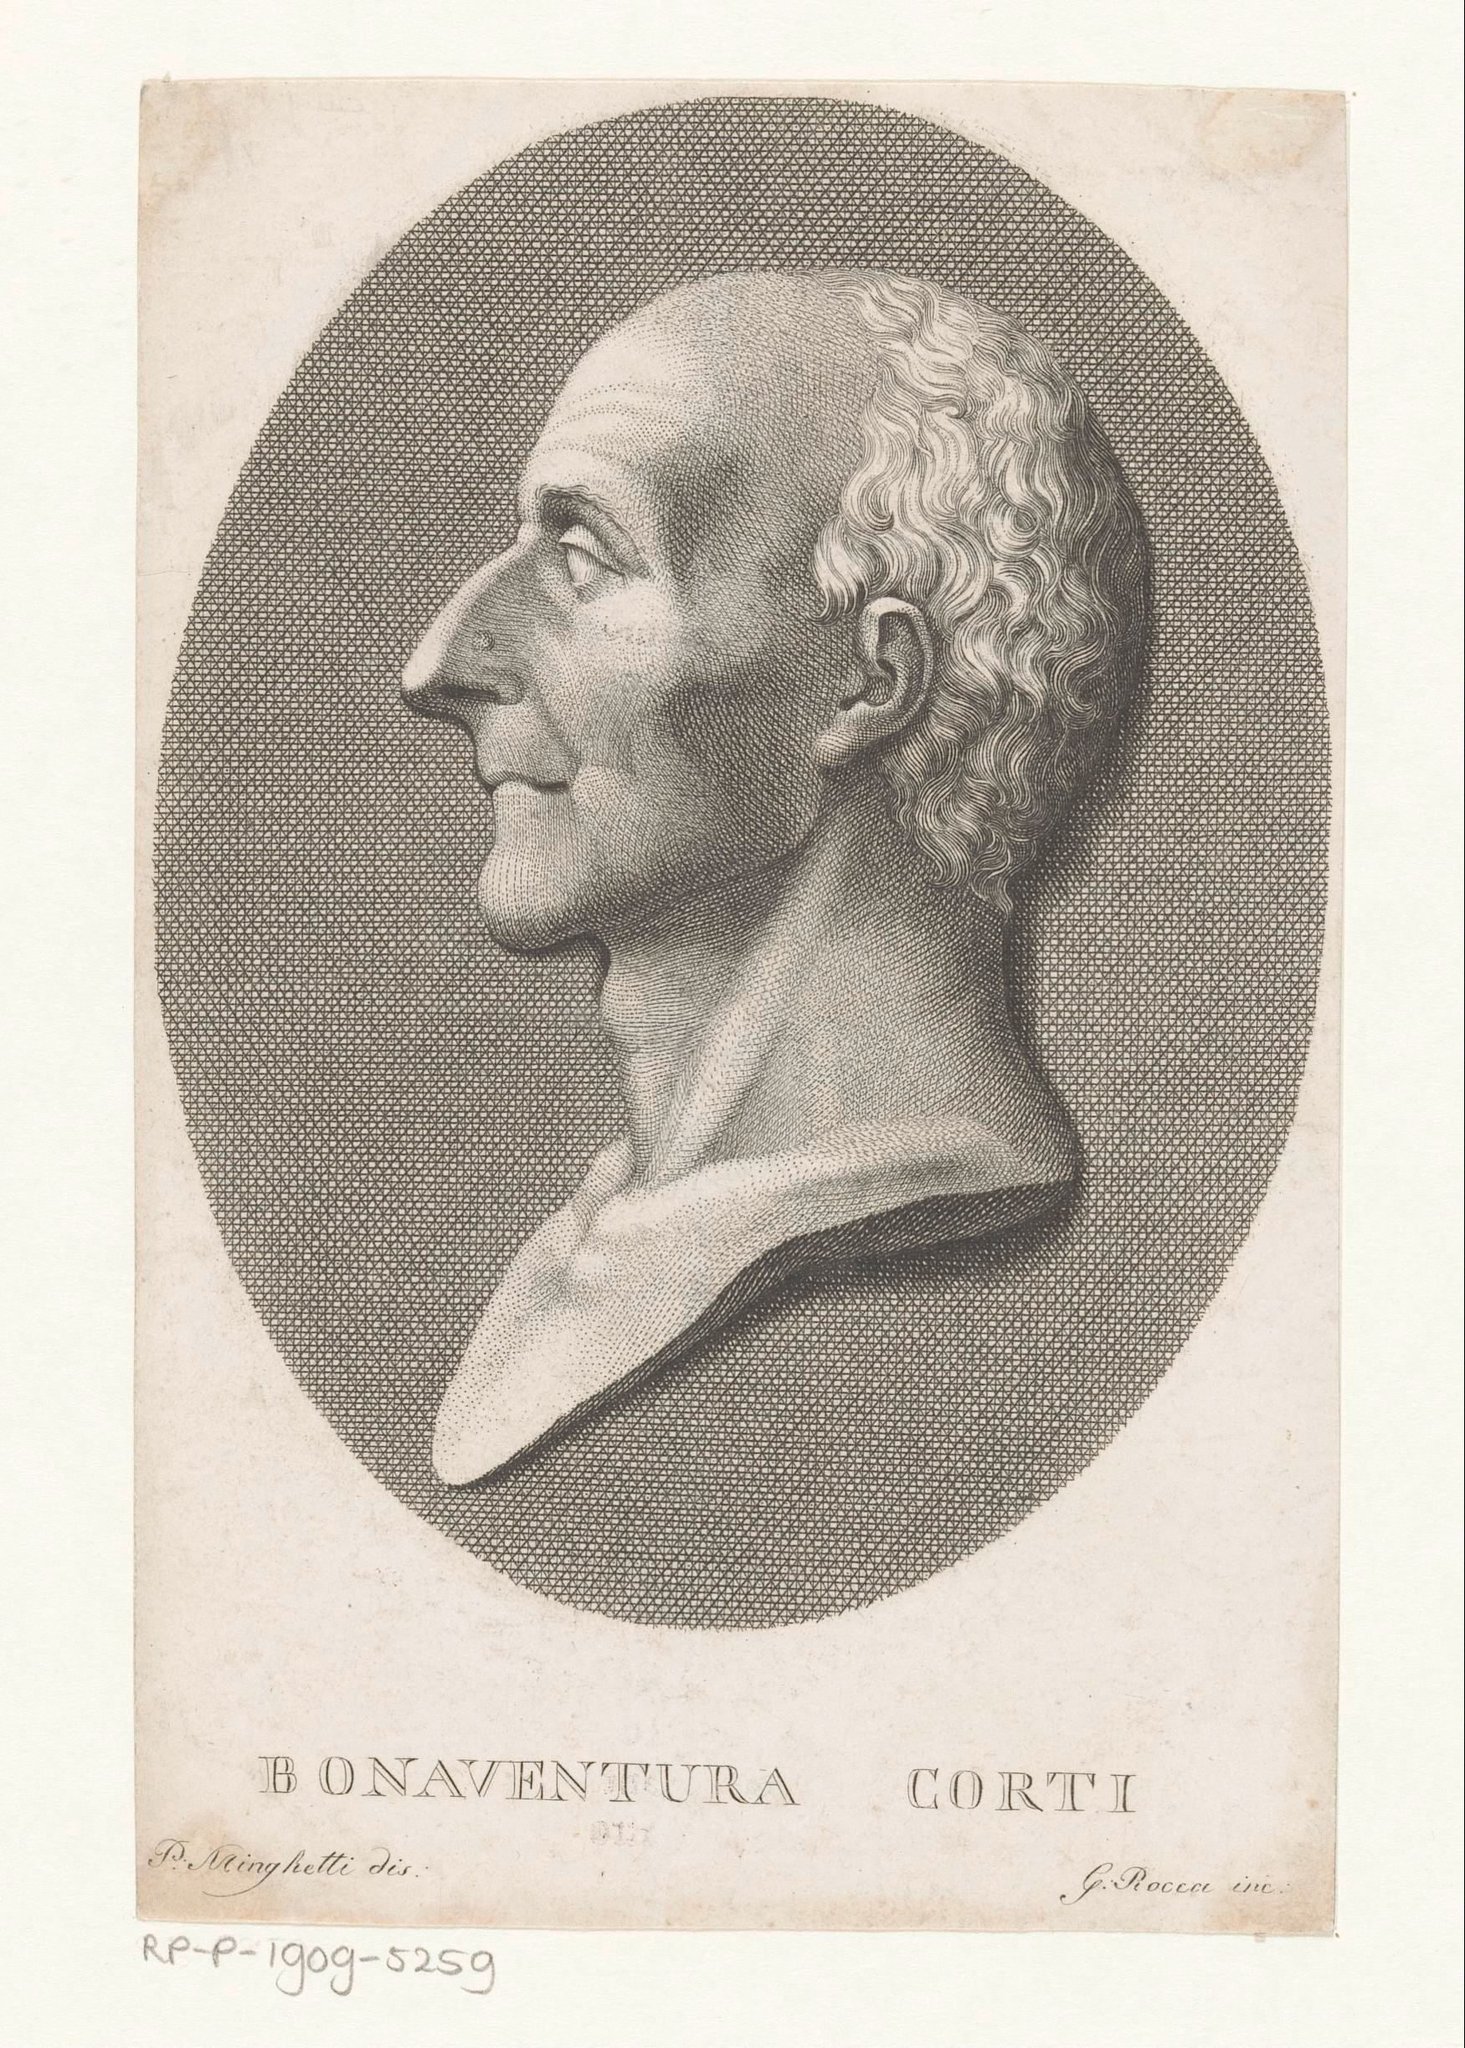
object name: print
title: Portret van botanicus Bonaventura Corti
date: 1798-1858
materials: paper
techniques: engraving, etching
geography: italy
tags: historical persons, science and technology (+ portrait of scholar, scientist)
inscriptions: collector's mark: Lugt 2228